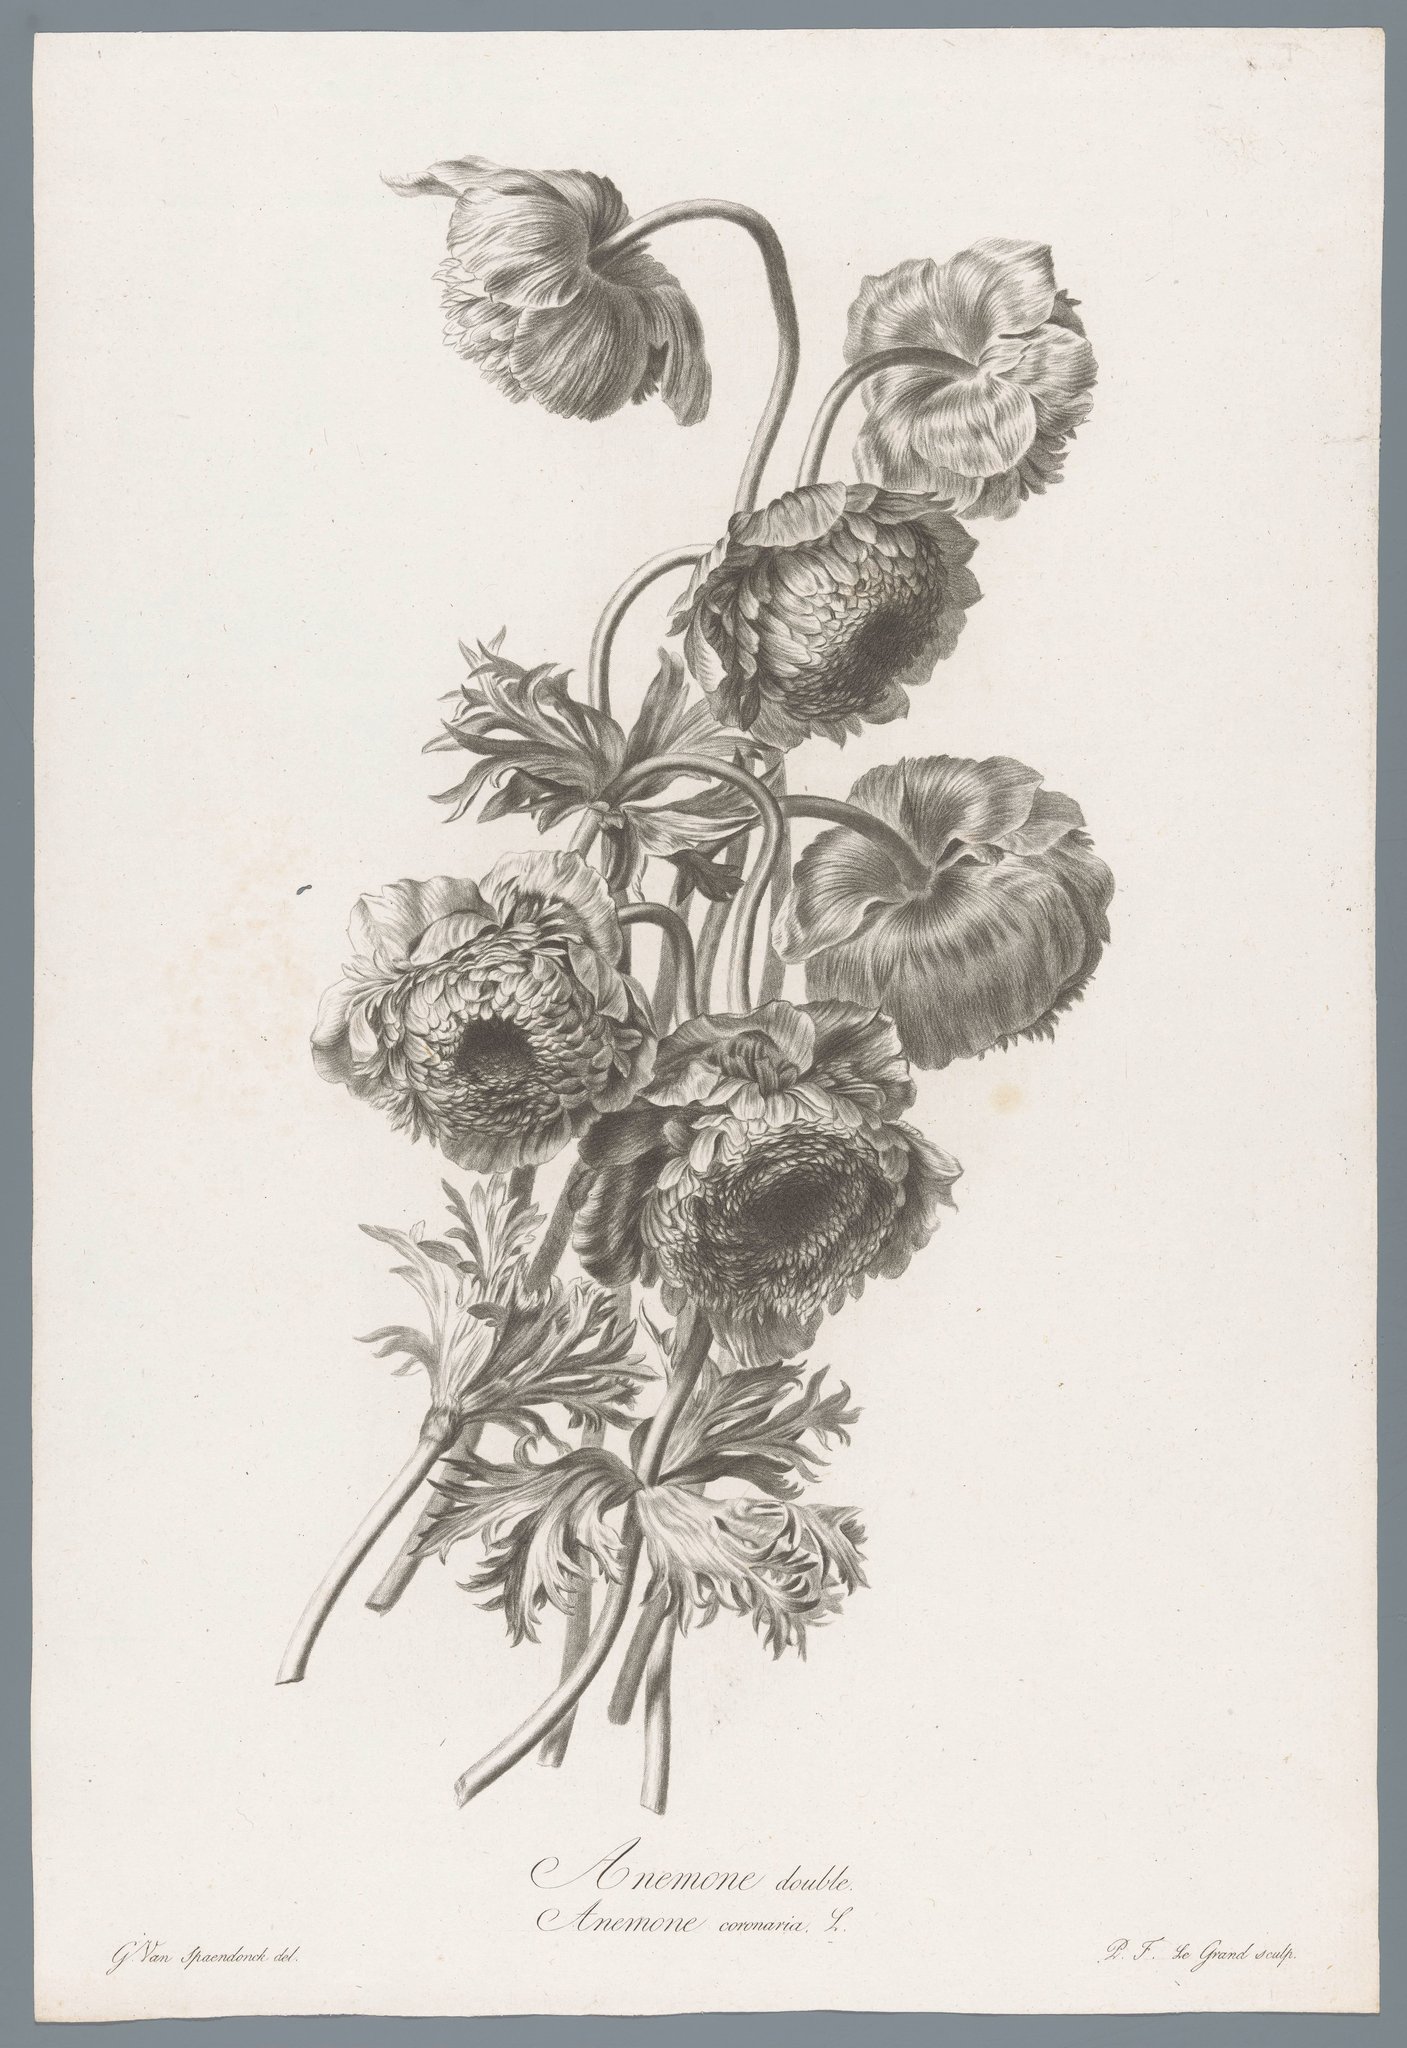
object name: ornament print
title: Knolanemoon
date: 1700-1801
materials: paper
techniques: engraving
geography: paris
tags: flowers: anemone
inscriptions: collector's mark: Lugt 2228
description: De serie Fleurs dessinées d'après nature (...) bestaat uit 24 prenten verdeeld over zes omslagen. Het Rijksprentenkabinet heeft 23 prenten in zes omslagen in bezit. De verdeling over de omslagen lijkt willekeurig. Zie RP-P-1909-4220 t/m 4242 en RP-P-2016-53 t/m 58.